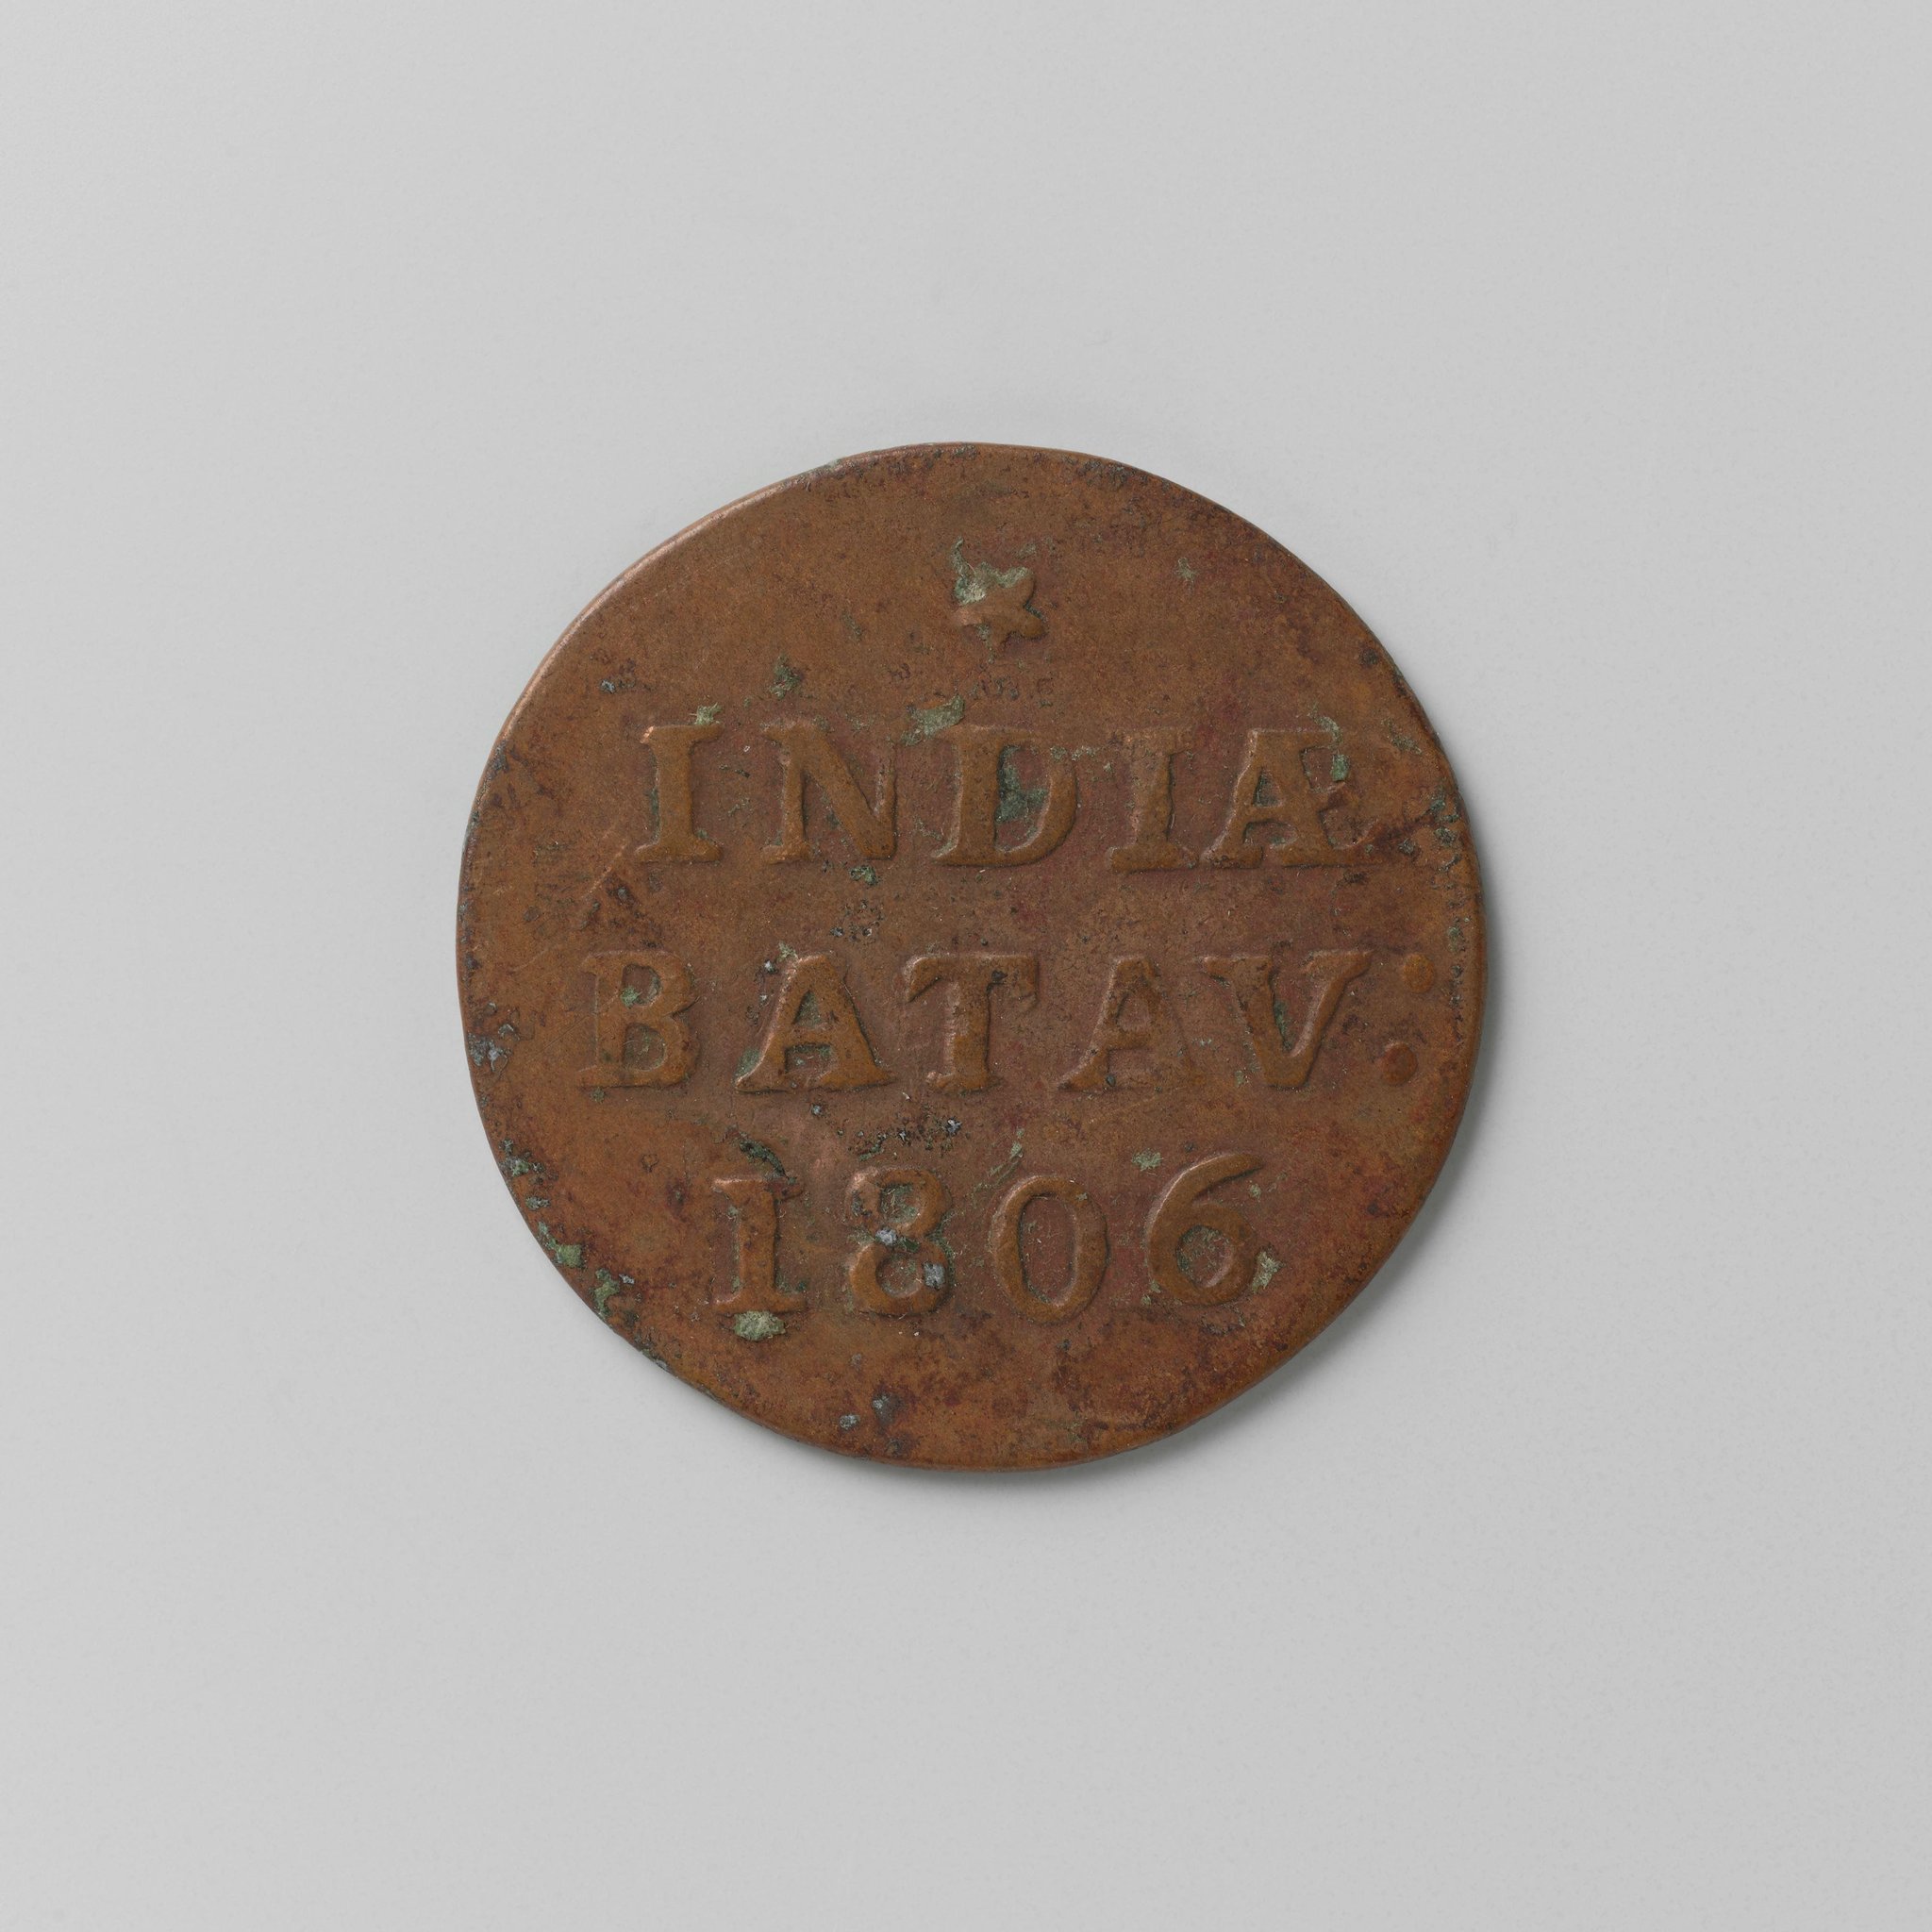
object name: coin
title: Nederlands Indië, duit Holland,1806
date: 1806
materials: copper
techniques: striking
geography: hoorn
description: Koperen munt. Voorzijde: tweeregelig opschrift, waarboven muntteken ster en waaronder jaartal. Keerzijde: tussen waarde-aanduiding 5 1/16 G gekroond generaliteitswapenschild. Gladde rand.